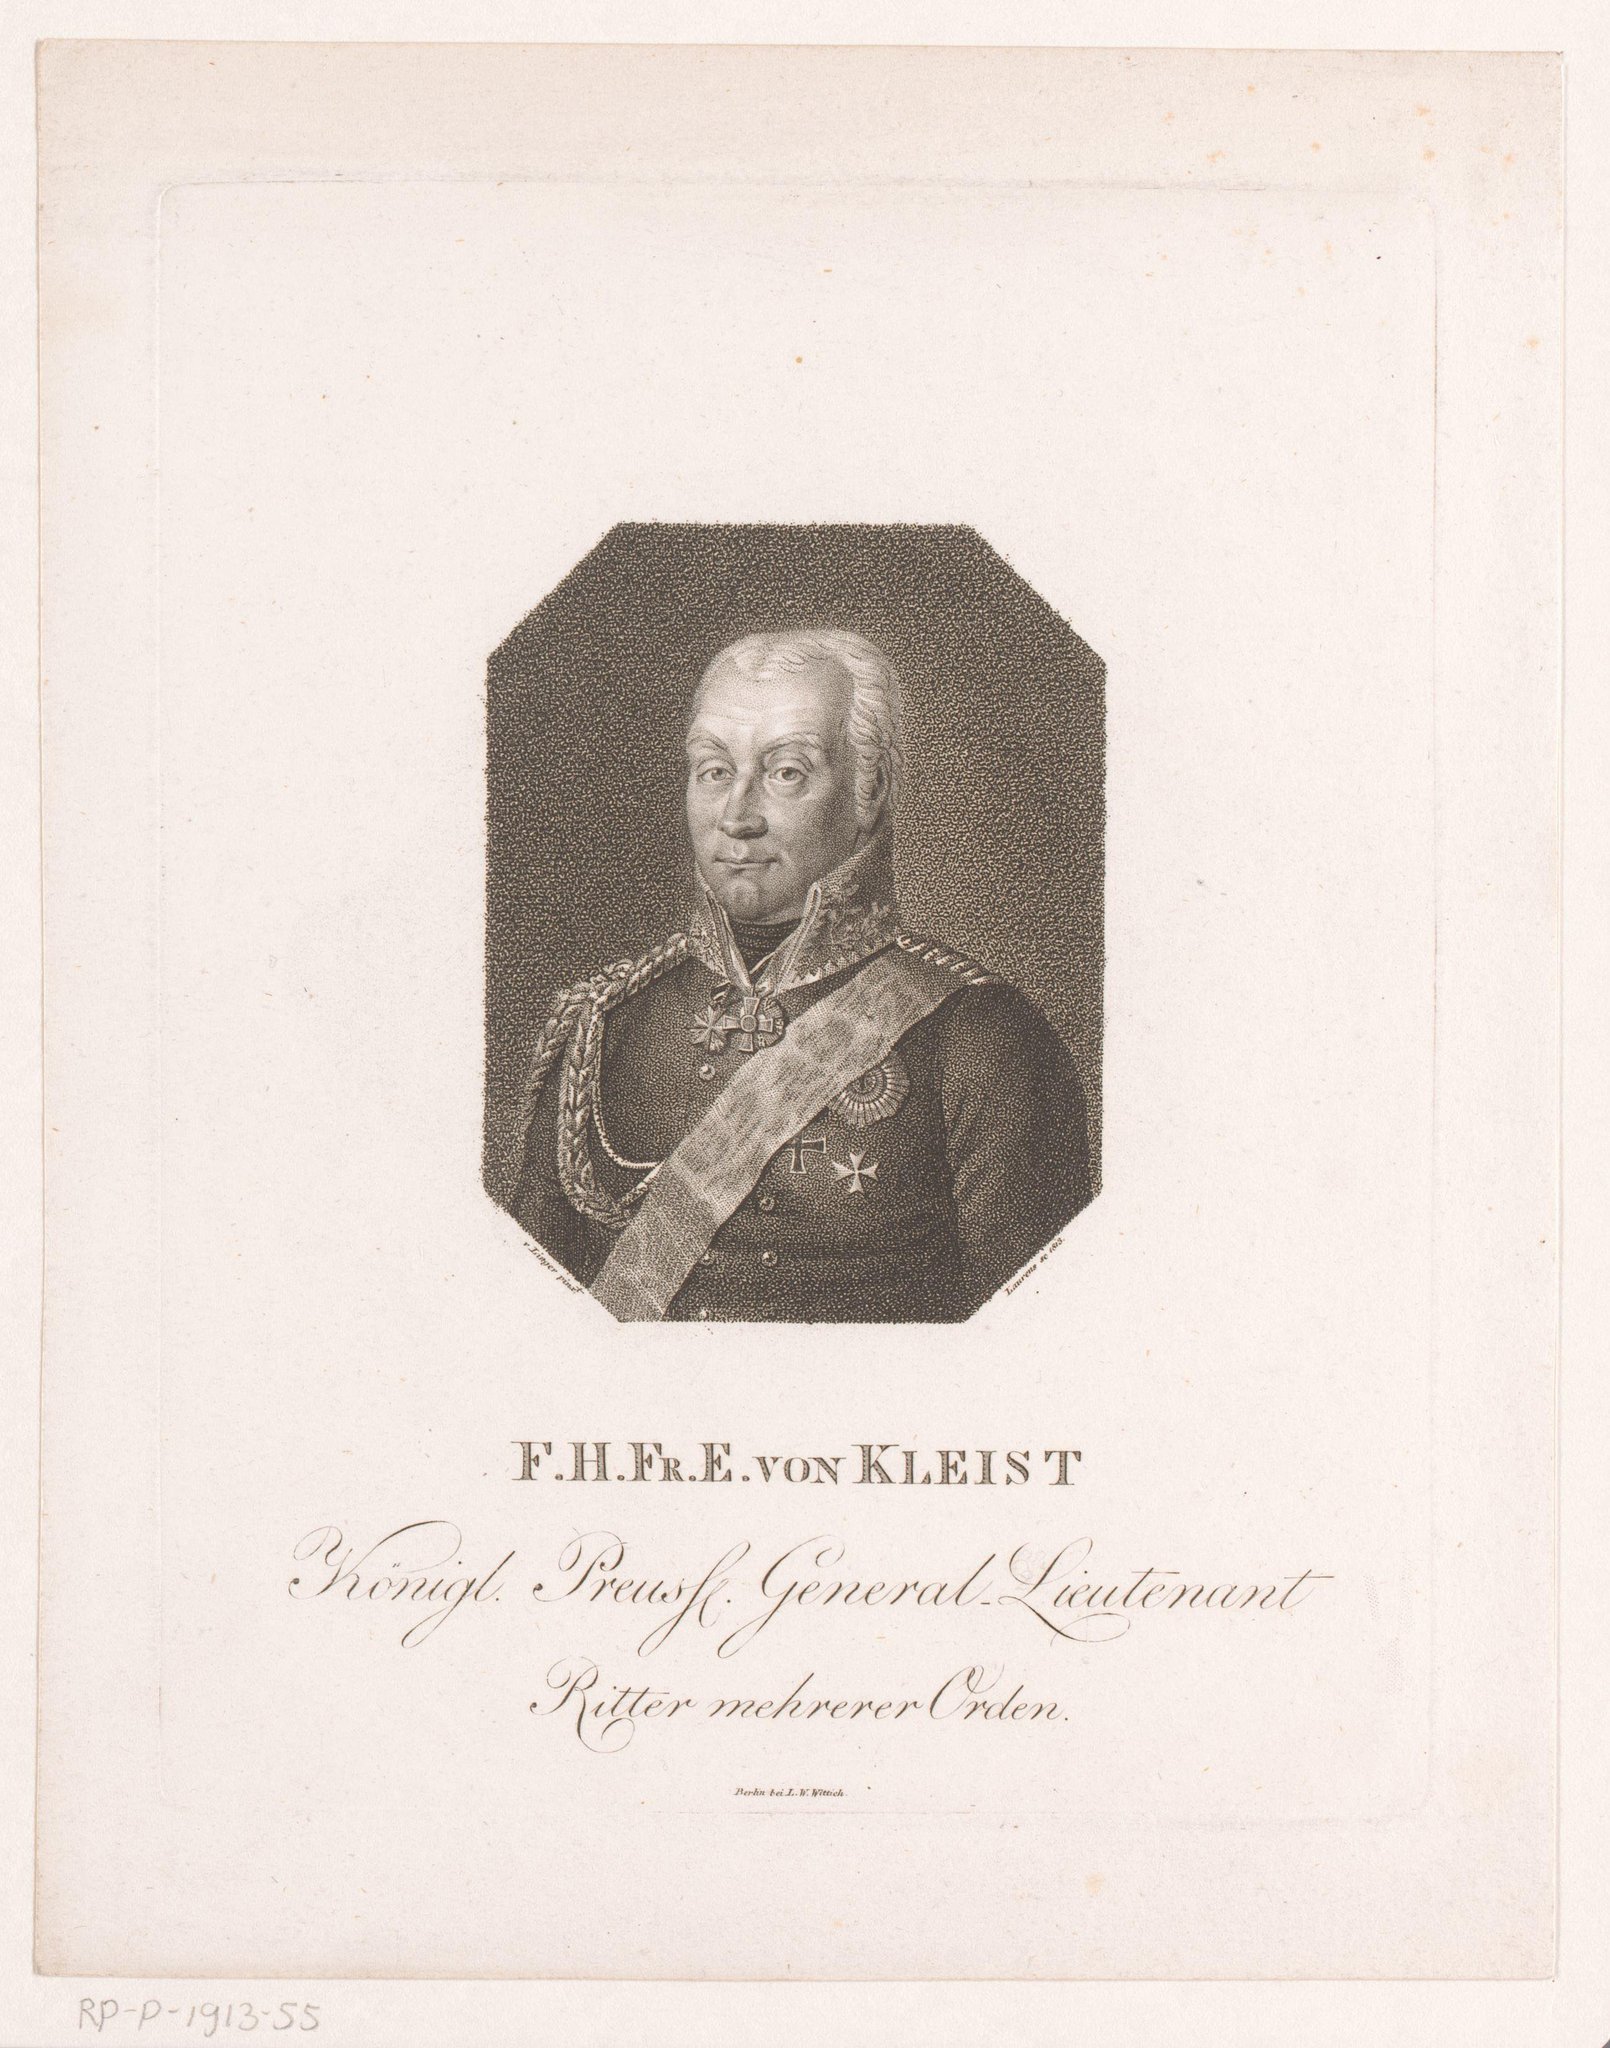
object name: print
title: Portret van Friedrich von Kleist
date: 1813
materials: paper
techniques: stippling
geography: berlin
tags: commander-in-chief, general, marshal, historical persons, medals and other marks of military honour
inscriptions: collector's mark: Lugt 2228